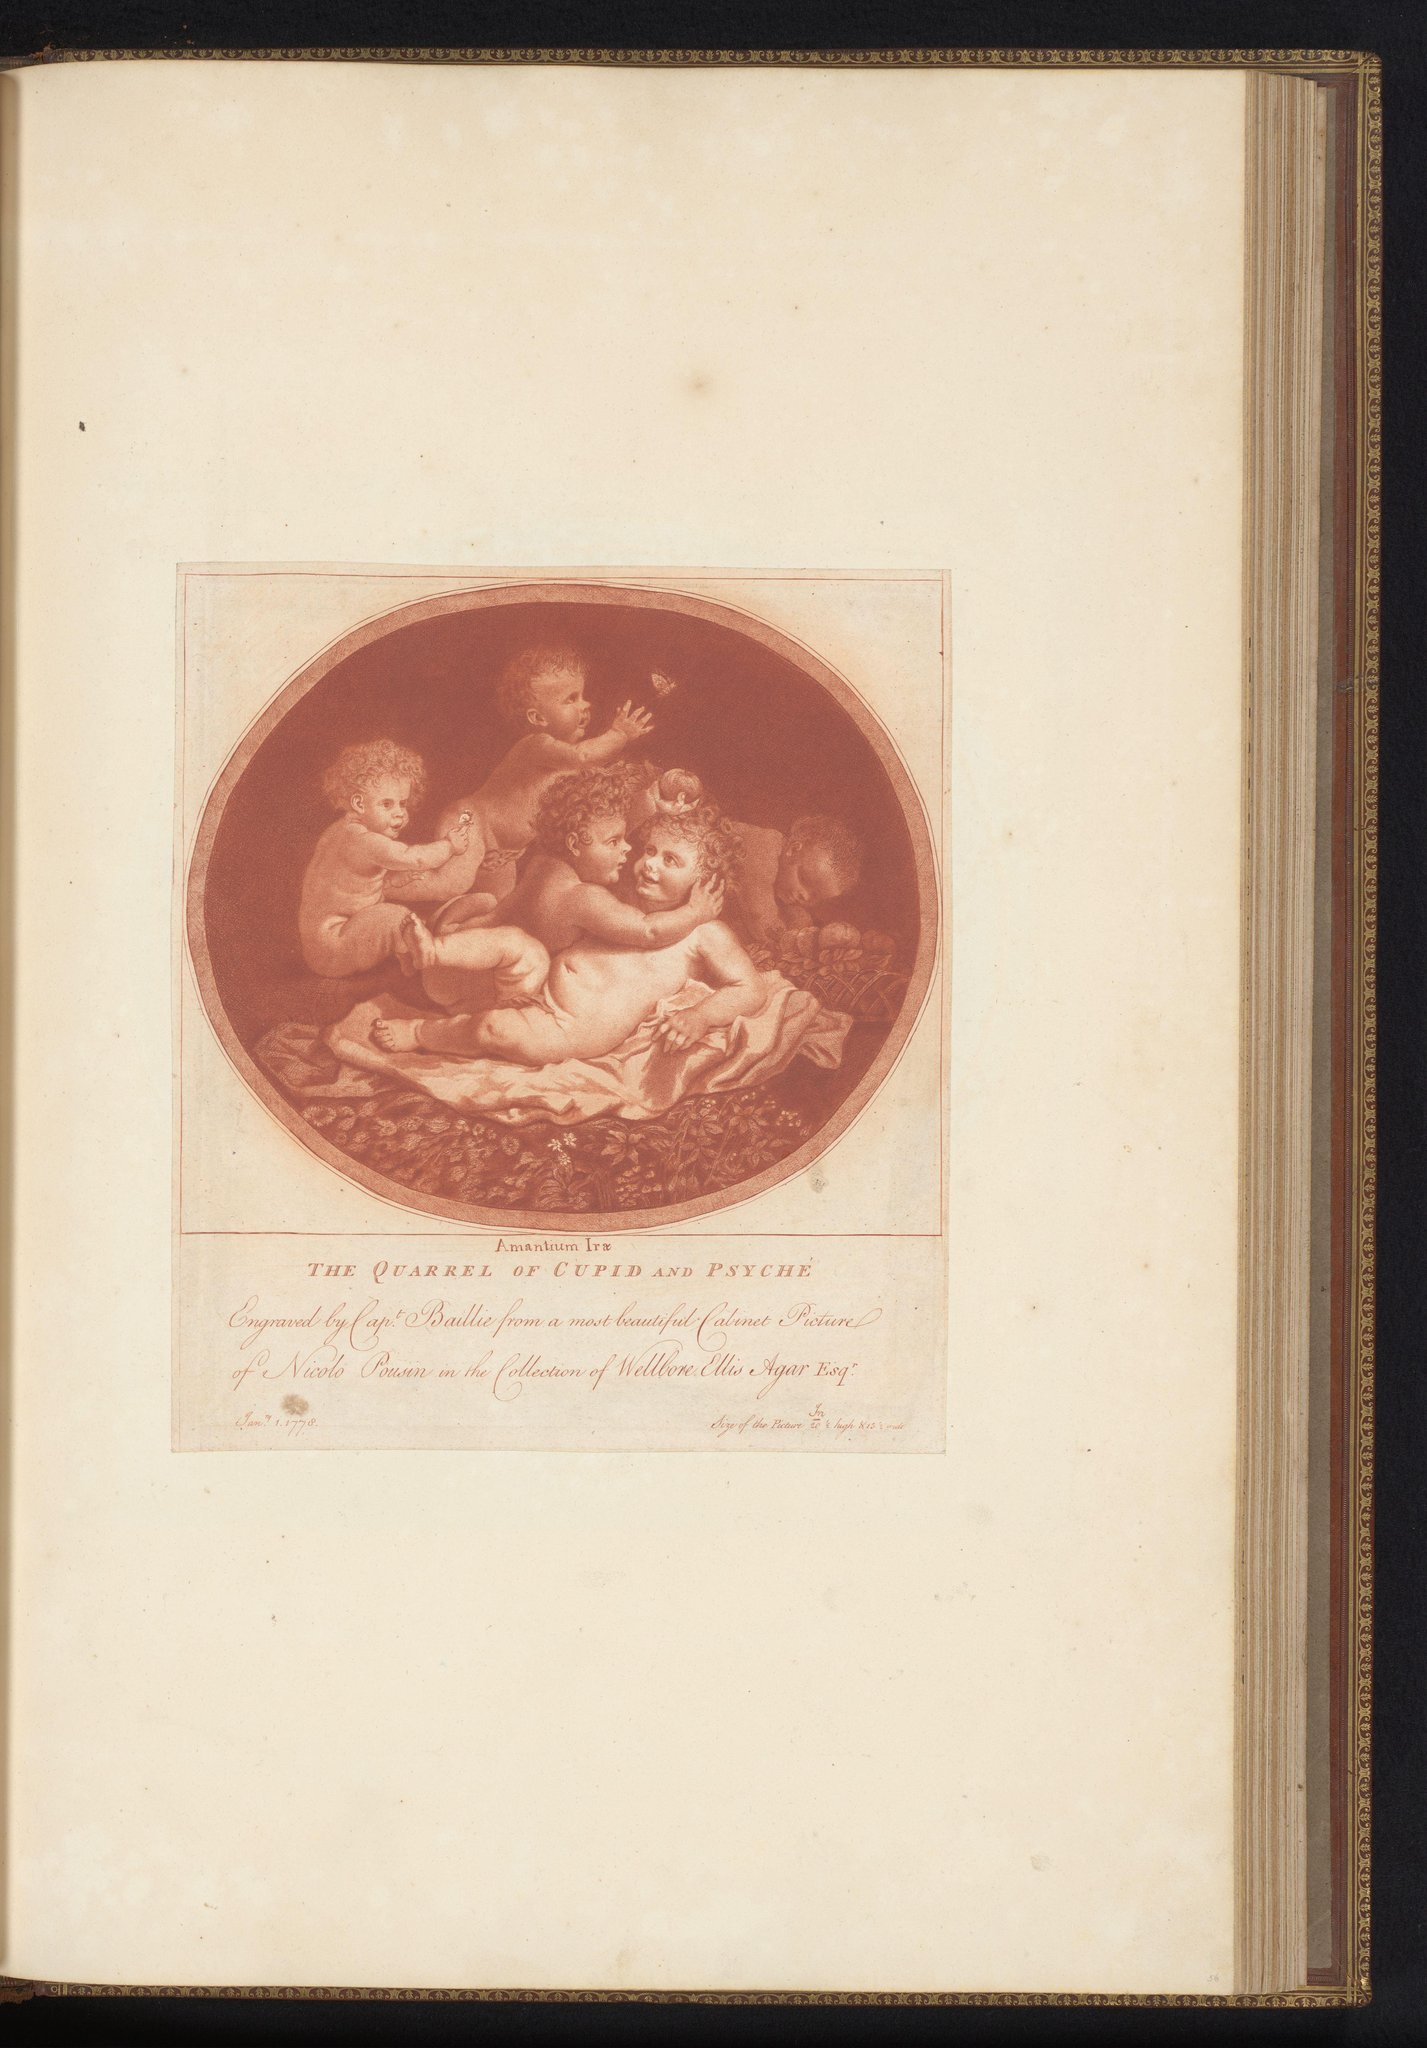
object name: print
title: Amantium Irae / The Quarrel of Cupid and Psycke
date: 1778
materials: paper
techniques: etching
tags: cupid and psyche as lovers, cupids: 'amores', 'amoretti', 'putti'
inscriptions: date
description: Twee putti omhelzen elkaar. Eén heeft een appel in zijn handen. Daarachter drie putti met een vlinder en een fruitmand. De prent maakt deel uit van een album.